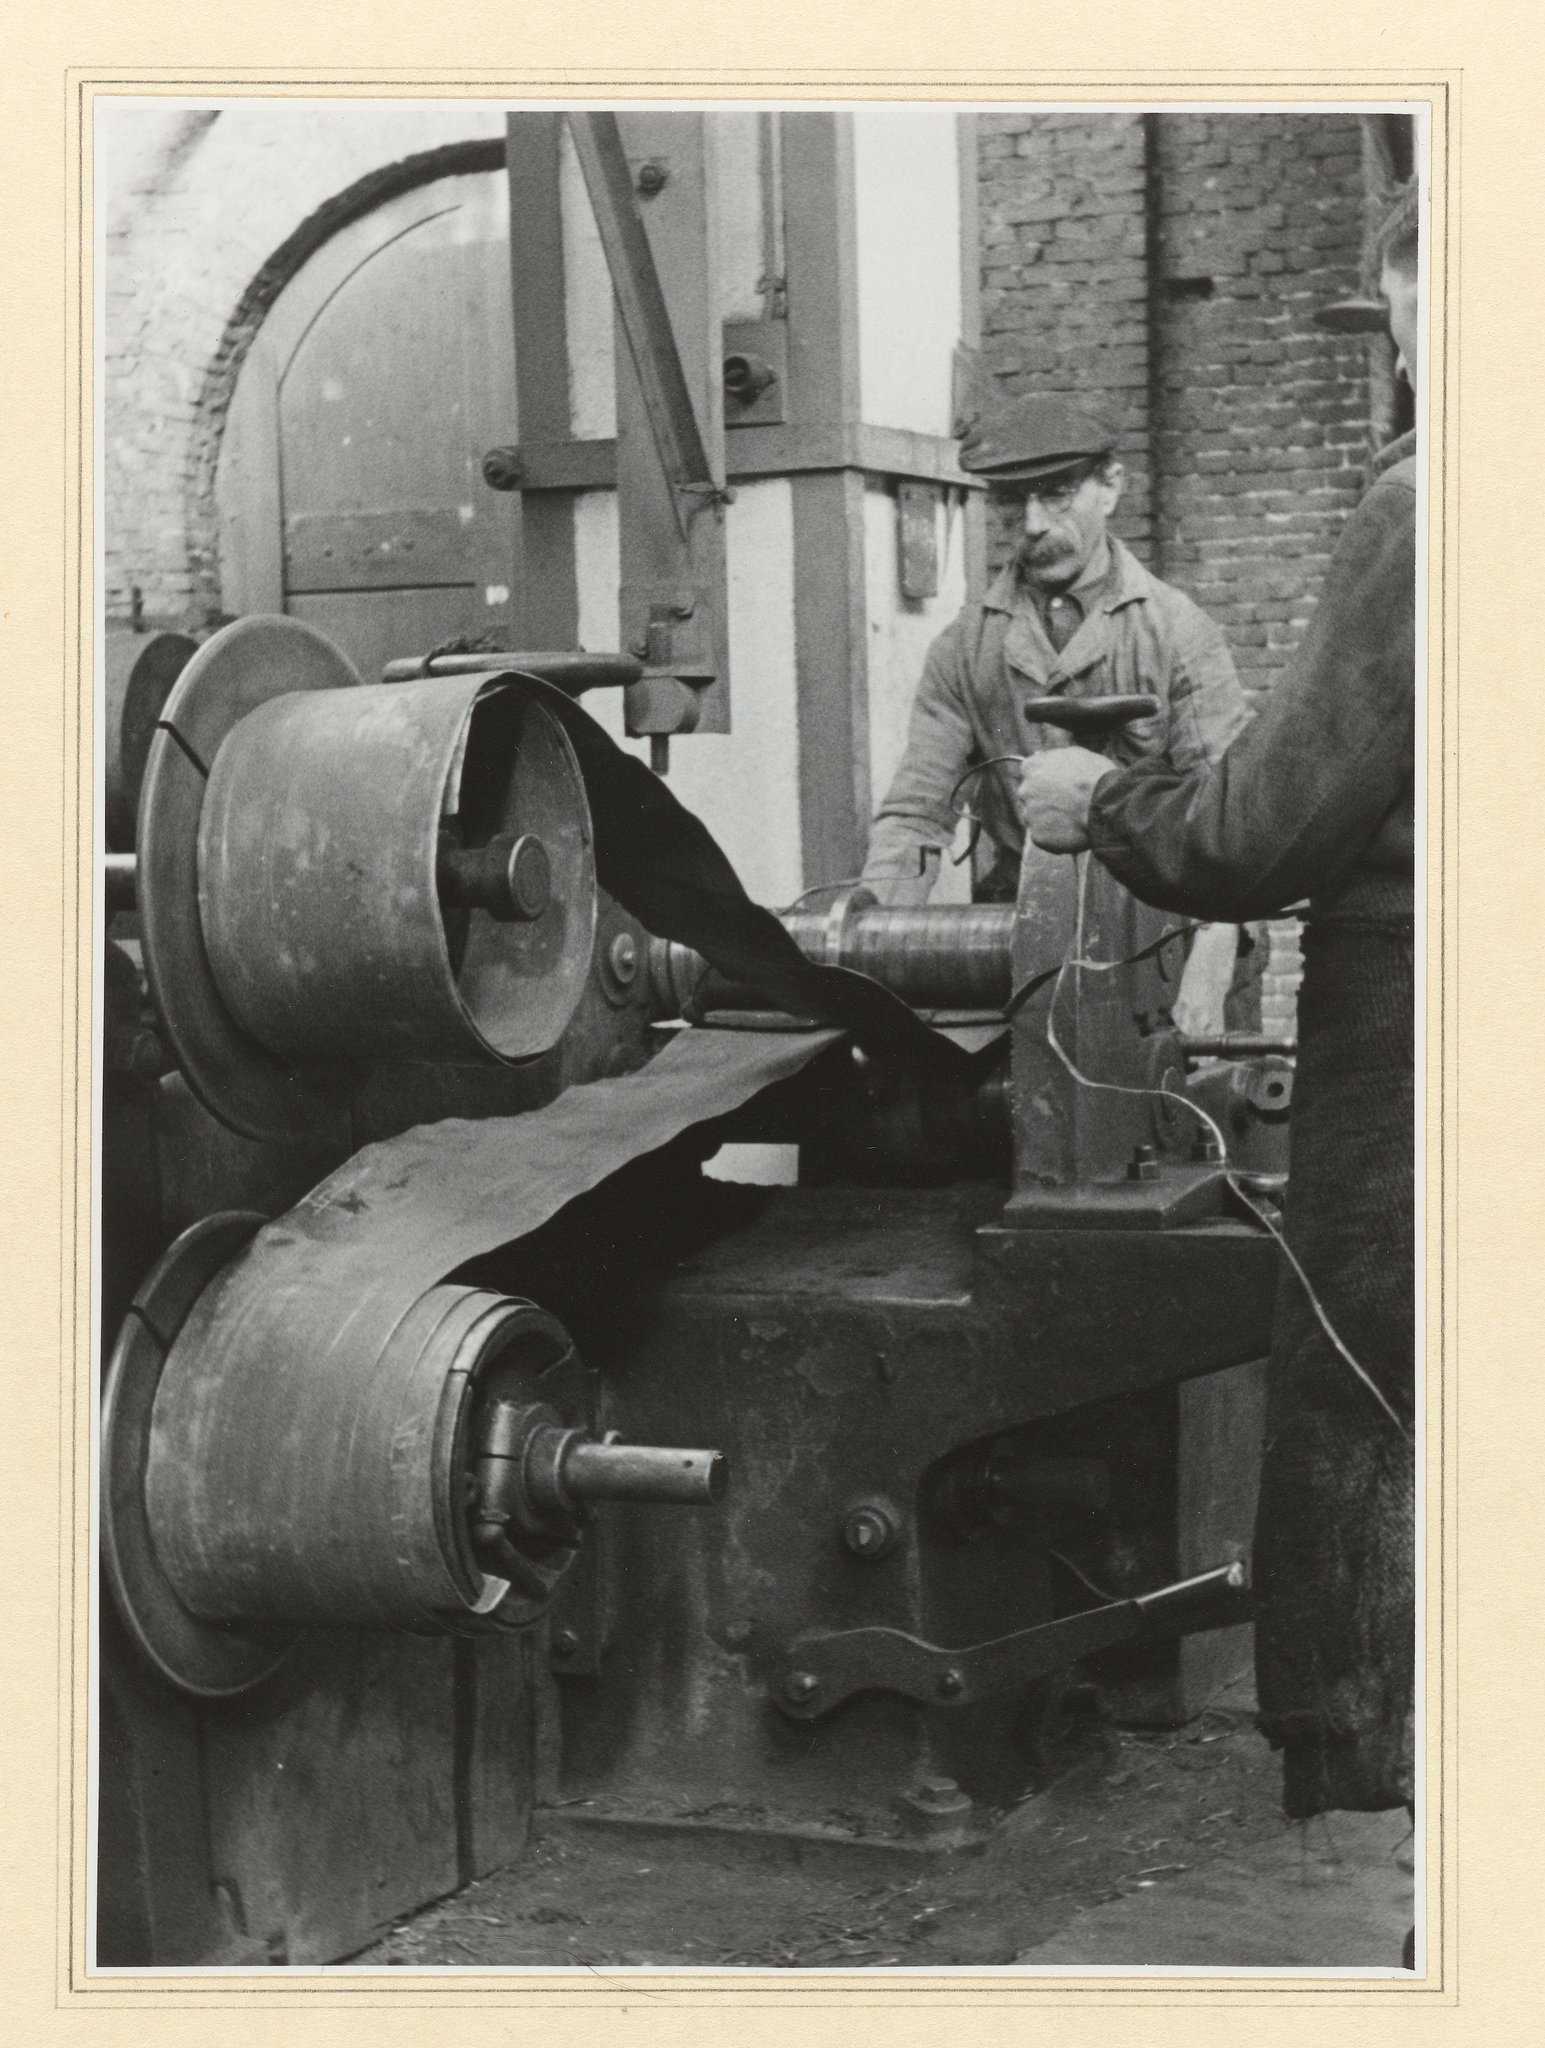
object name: photograph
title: Metaalarbeiders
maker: Anonymous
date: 1920-1980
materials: paper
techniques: gelatin silver print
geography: netherlands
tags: workshop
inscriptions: inscription: ‘Van Dirk 83.1226’, stamp: ‘DH’